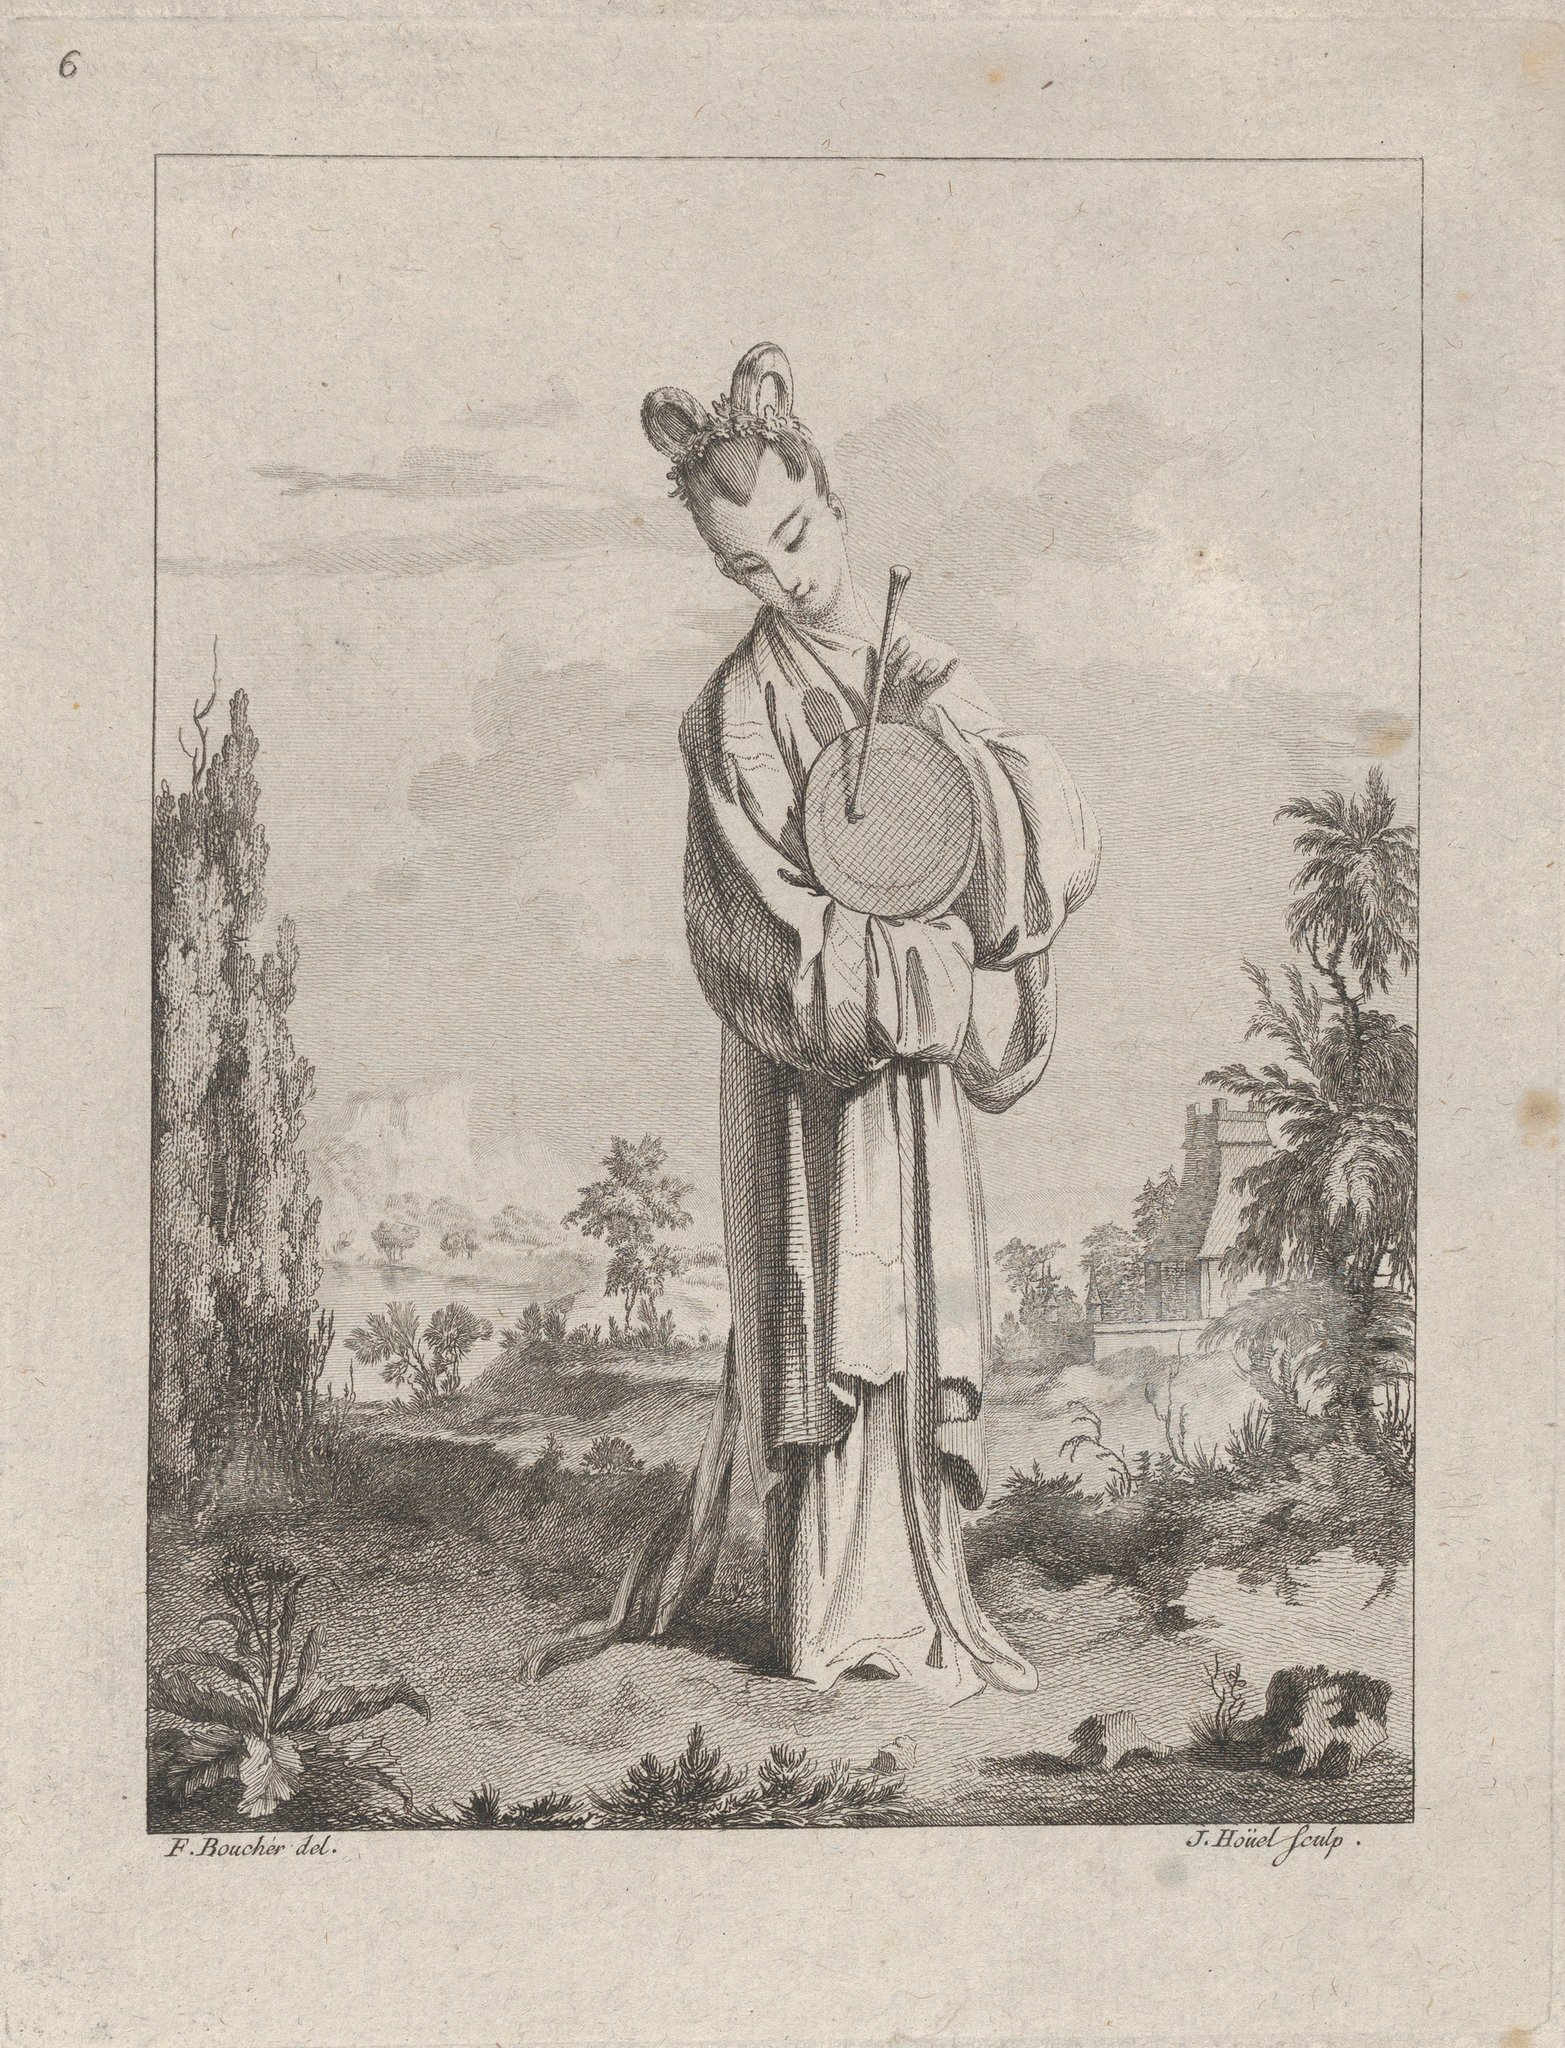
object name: print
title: Chinoiserie with a woman playing a gong, from Suite de Figures Chinoises. . .Tiré du Cabinet de Mr. d'Azaincourt (Series of Chinoiserie Figures. . .From the Chambers of Mr. d'Azaincourt), plate 6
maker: jean pierre louis laurent hoüel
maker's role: artist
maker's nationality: french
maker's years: 1735-1813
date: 1755-1776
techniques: engraving, etching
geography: france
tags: musical instruments,chinoiserie,women